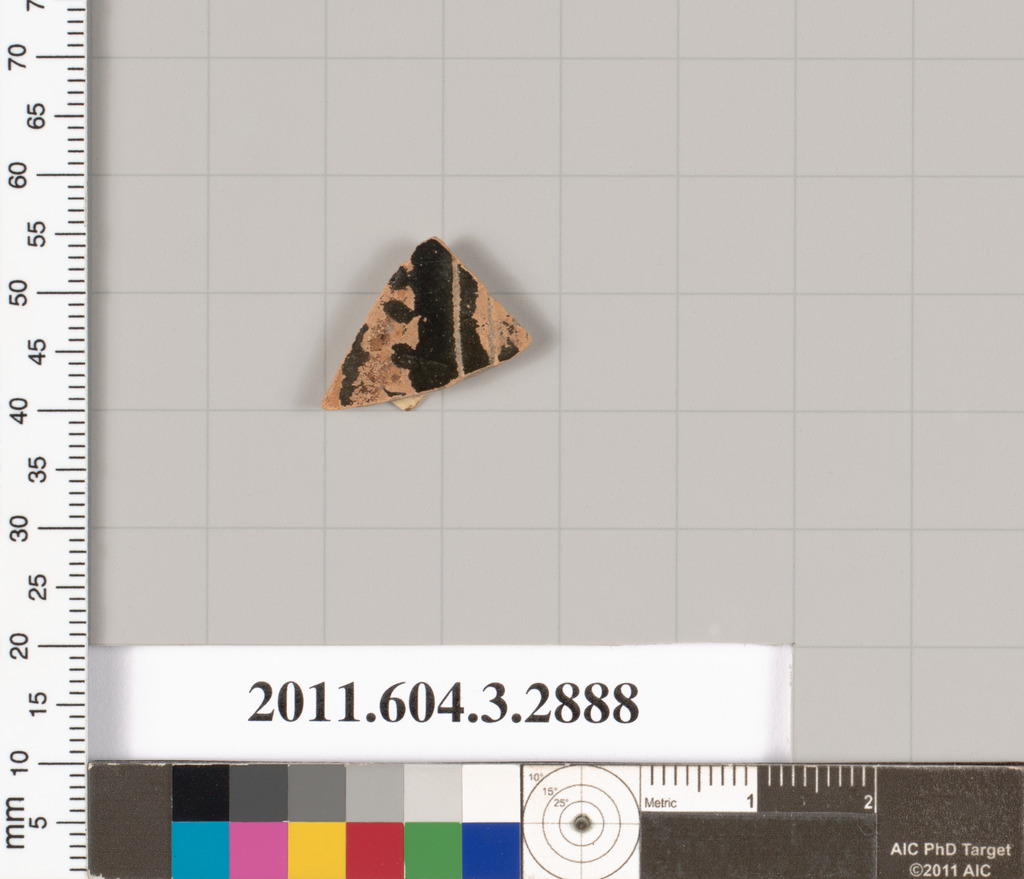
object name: undetermined closed shape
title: Terracotta fragment of a closed shape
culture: greek, attic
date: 600-401 BCE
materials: terracotta